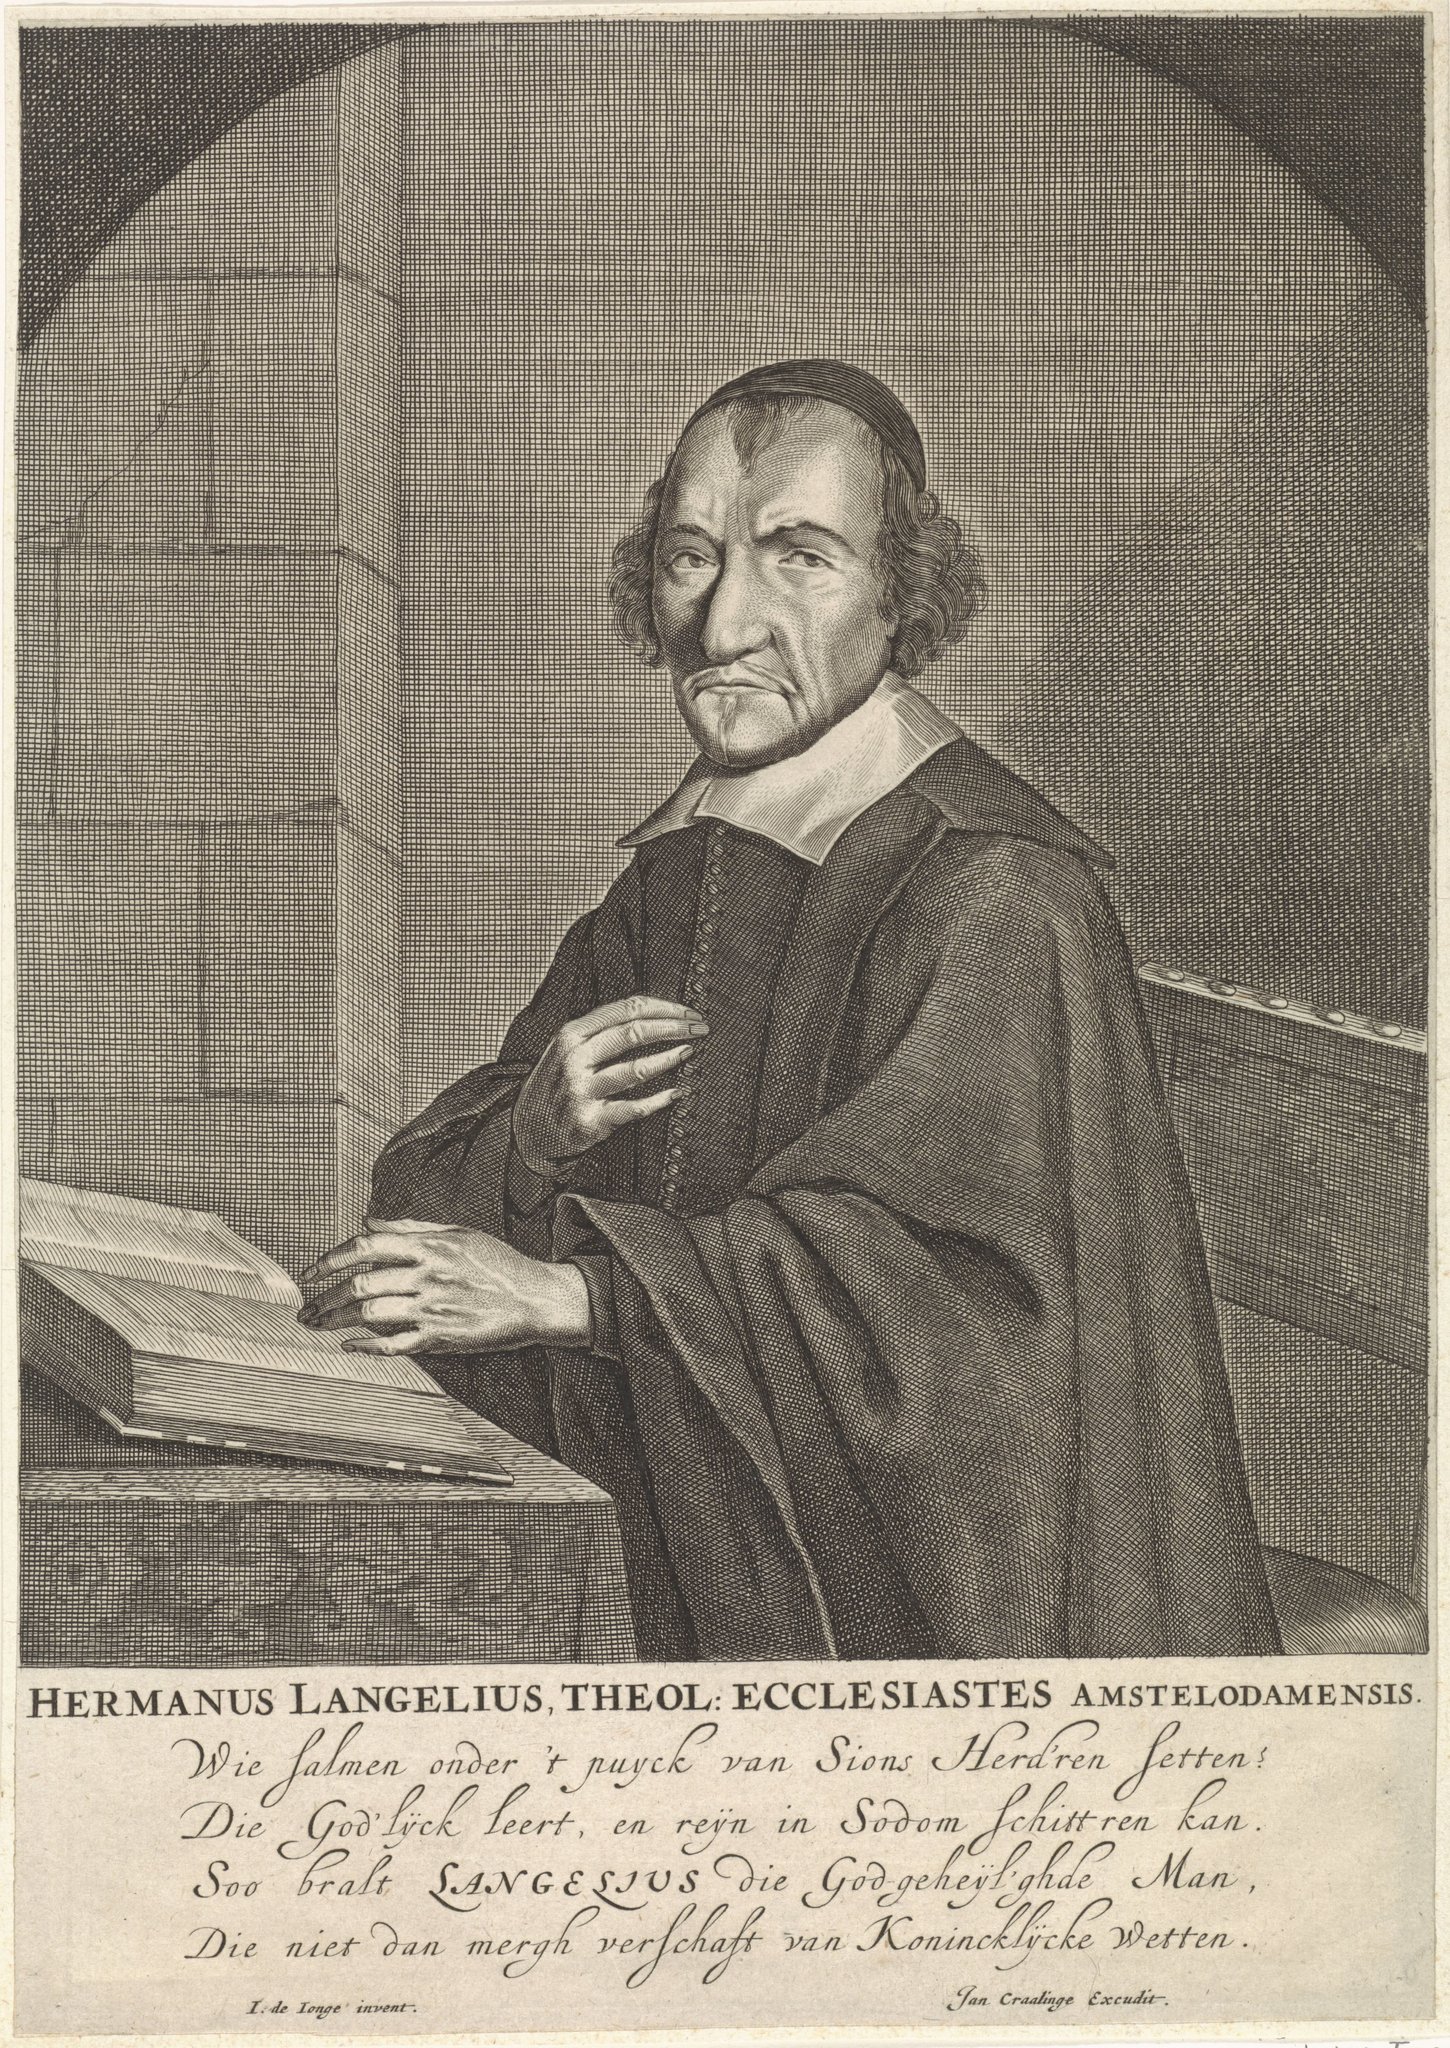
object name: print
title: Portret van de Amsterdamse predikant Hermanus Langelius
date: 1655-1673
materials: paper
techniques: engraving, etching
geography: amsterdam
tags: predikant, hermanus langelius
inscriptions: collector's mark: Lugt 2228